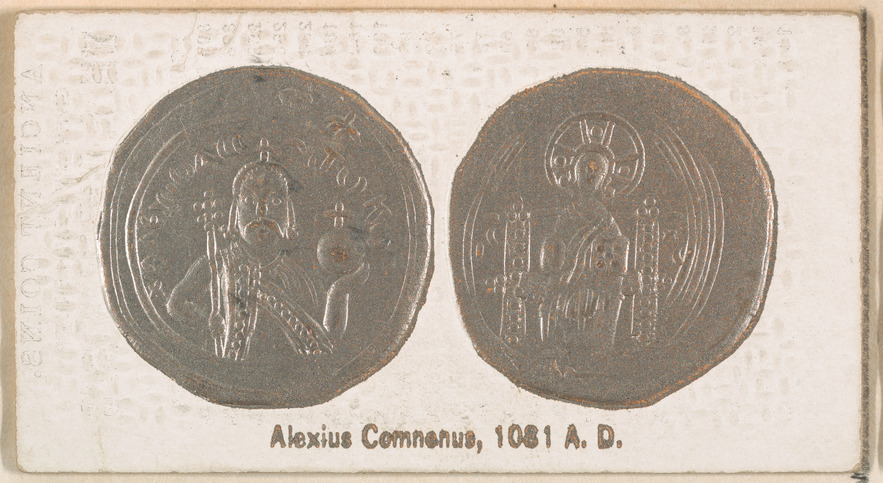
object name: print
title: Alexius Comnenus, 1081 A.D., from the Ancient Coins series (N180) issued by Wm. S. Kimball & Co.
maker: william s. kimball & company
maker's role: publisher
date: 1888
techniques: color lithograph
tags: coins